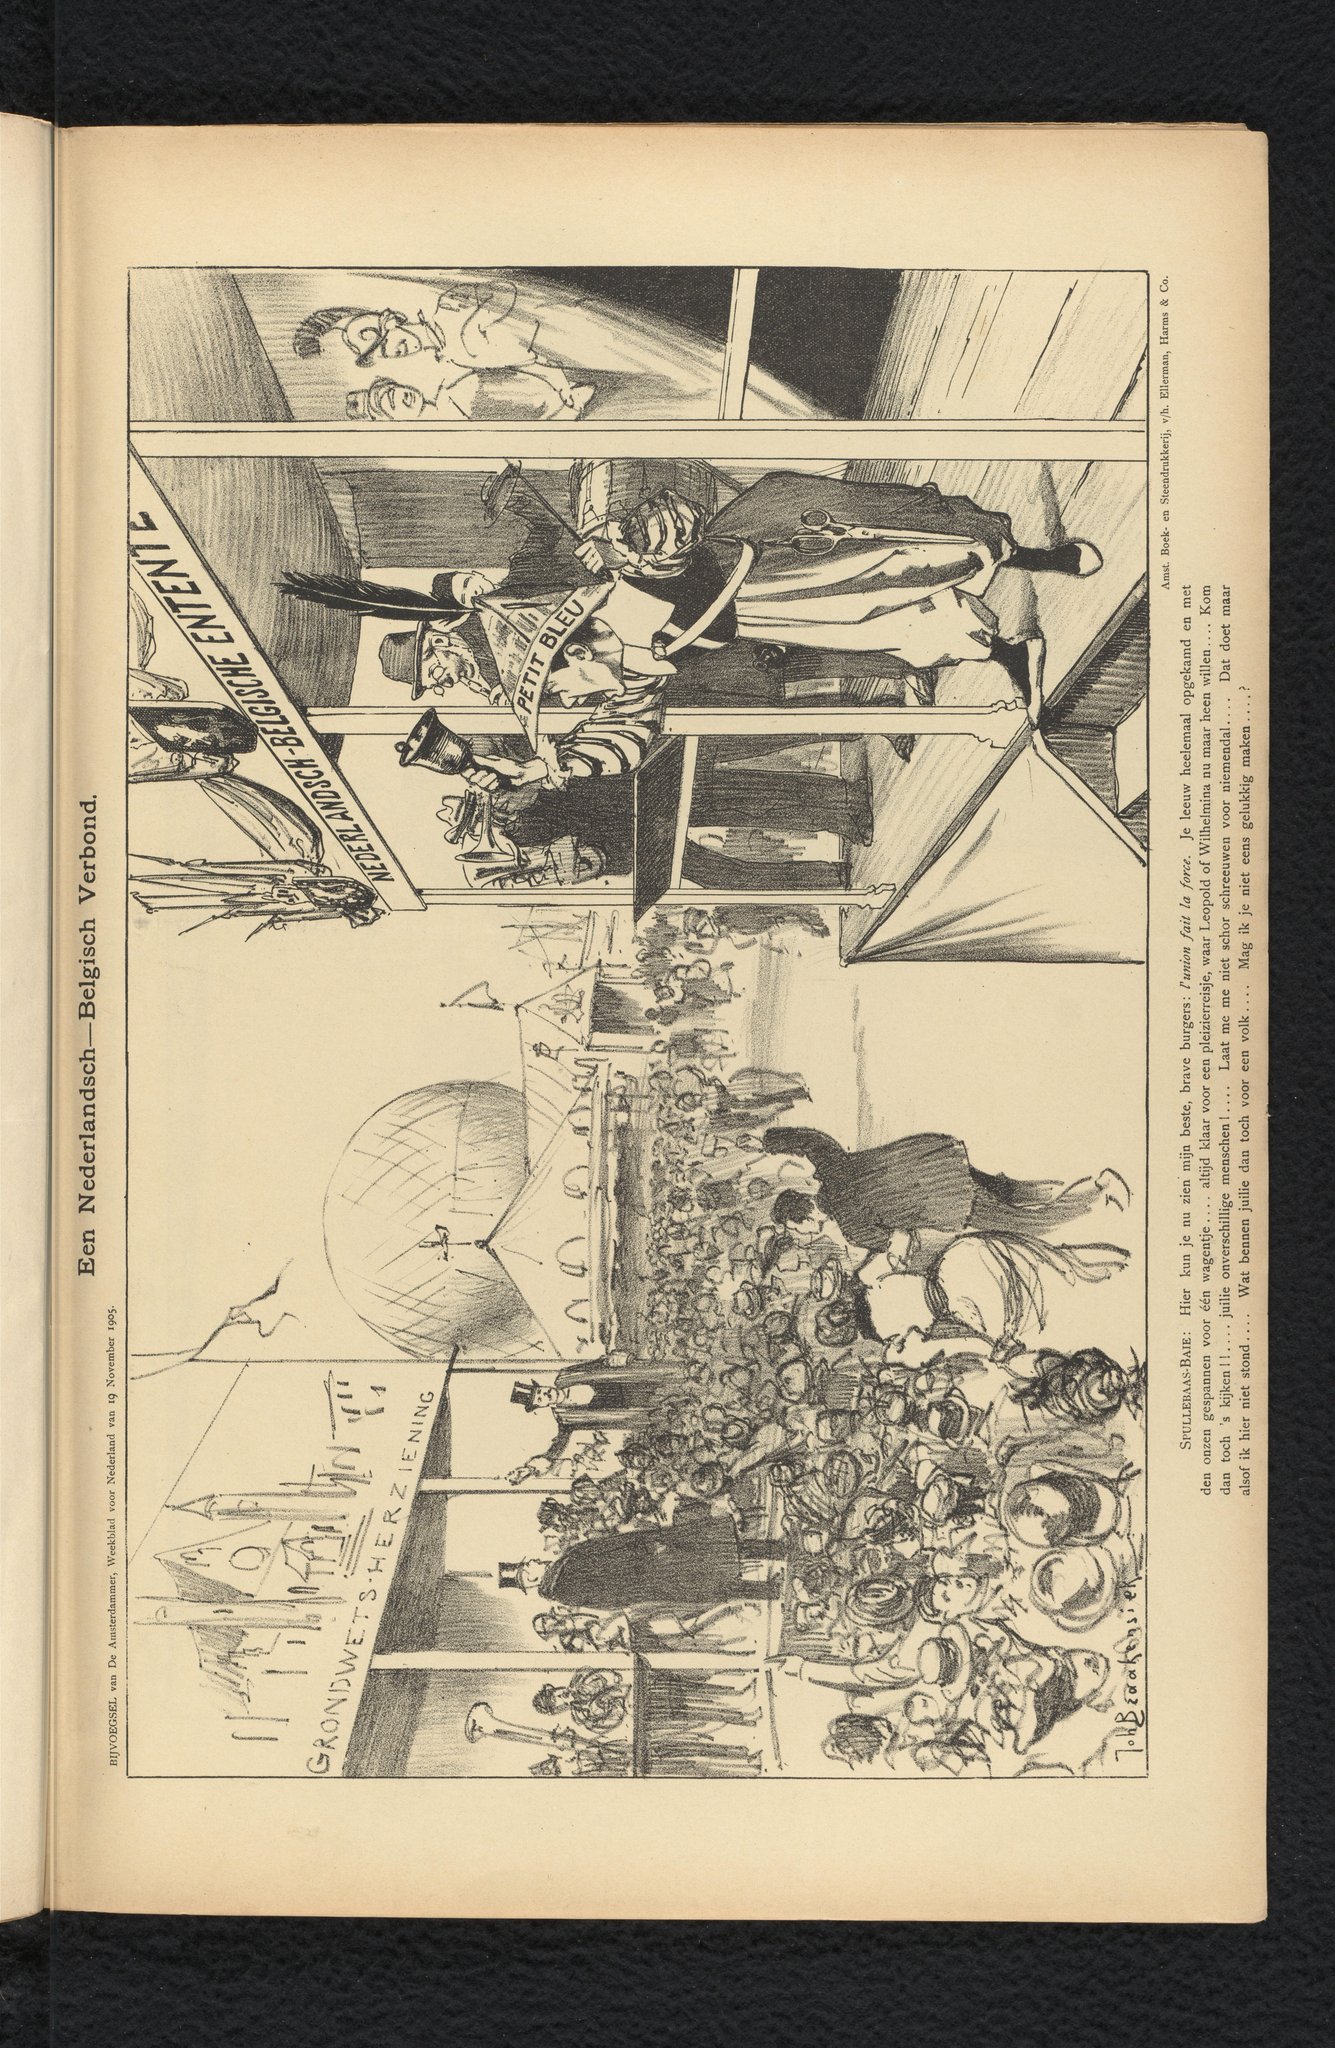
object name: cartoon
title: Een Nederlandsch-Belgisch Verbond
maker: johan braakensiek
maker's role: draughtsman, print maker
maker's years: 1858-1940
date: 1905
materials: paper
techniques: lithograph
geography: amsterdam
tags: circus tent (outside), pleasure fair and circus, political caricatures and satires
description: Op de kermis is er geen publieke belangstelling voor het verbond tussen Nederland en België, ondanks de aanprijzingen van de promotor 'Spullebaas-Baie'. Het publiek verzamelt zich wel aan de overkant voor de tent 'Grondwetsherziening'.